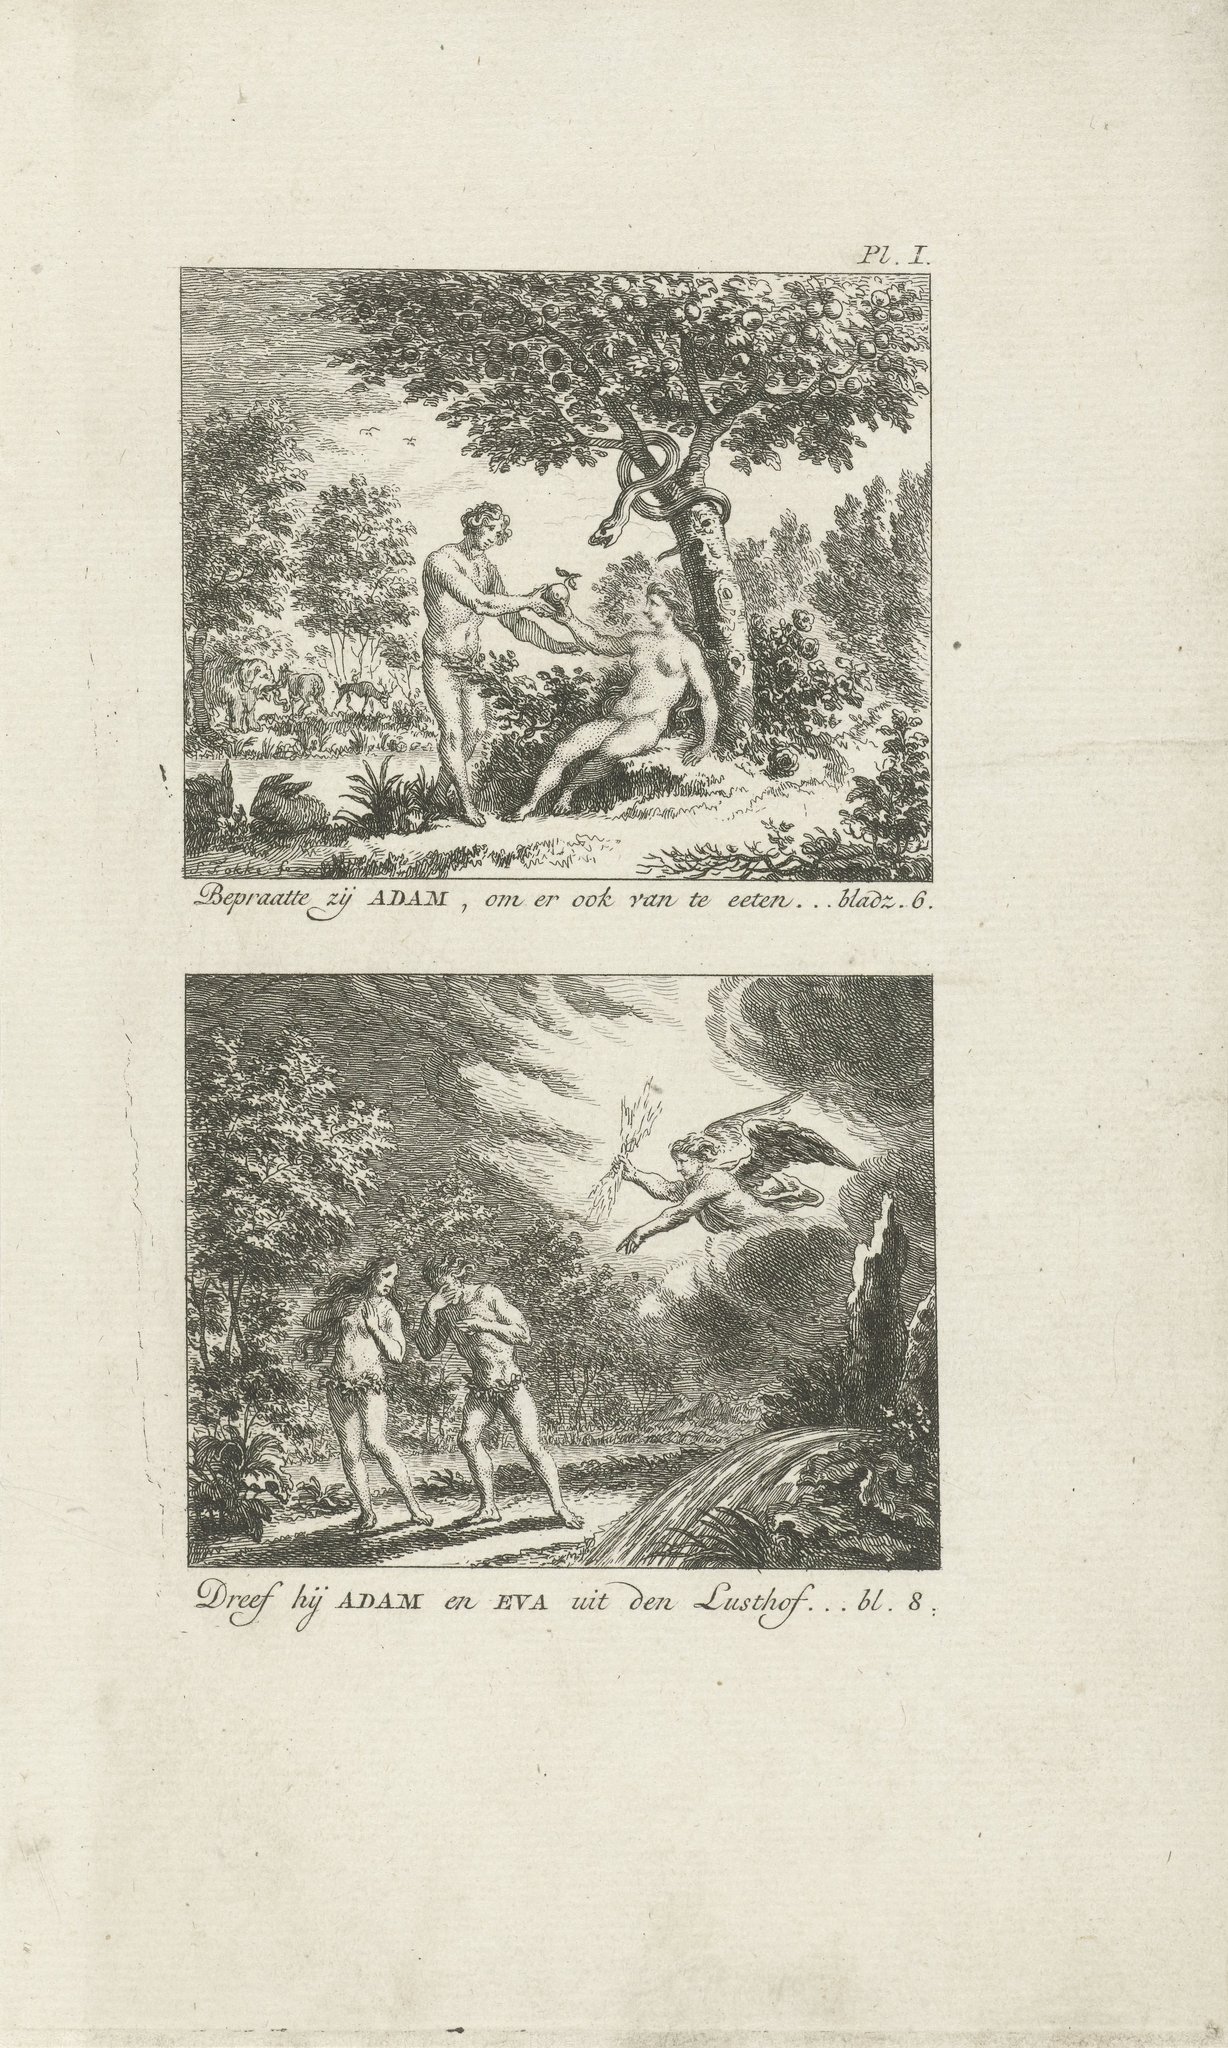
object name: print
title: Zondeval, en verdrijving uit het paradijs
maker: simon fokke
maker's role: draughtsman, print maker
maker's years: 1712-1784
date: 1722-1784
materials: paper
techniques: etching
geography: amsterdam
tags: eve offers the fruit to adam, expulsion of adam and eve from paradise (genesis 3:22-24)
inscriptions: collector's mark: Lugt 2228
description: Scènes uit het Oude Testament. Boven: Adam en Eva bevinden zich in het paradijs onder de boom van Goed en Kwaad waarin de slang tussen de takken kronkelt. Eva reikt Adam een vrucht aan. Onder: Adam en Eva worden uit het paradijs verdreven door een engel die een bundel bliksemschichten vasthoudt. Twee voorstellingen van één plaat, rechtsboven gemerkt: Pl. I.